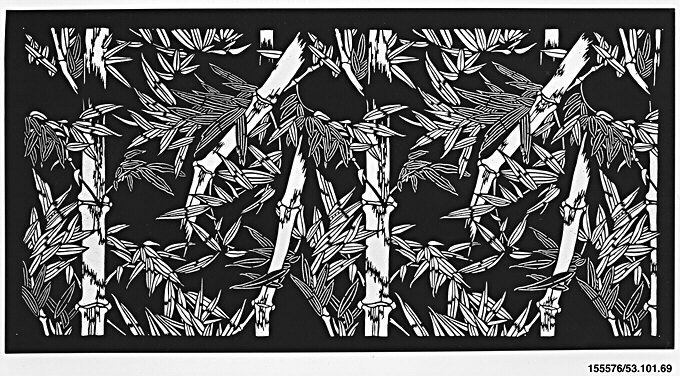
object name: stencil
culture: japanese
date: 1615-1868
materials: paper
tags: bamboo